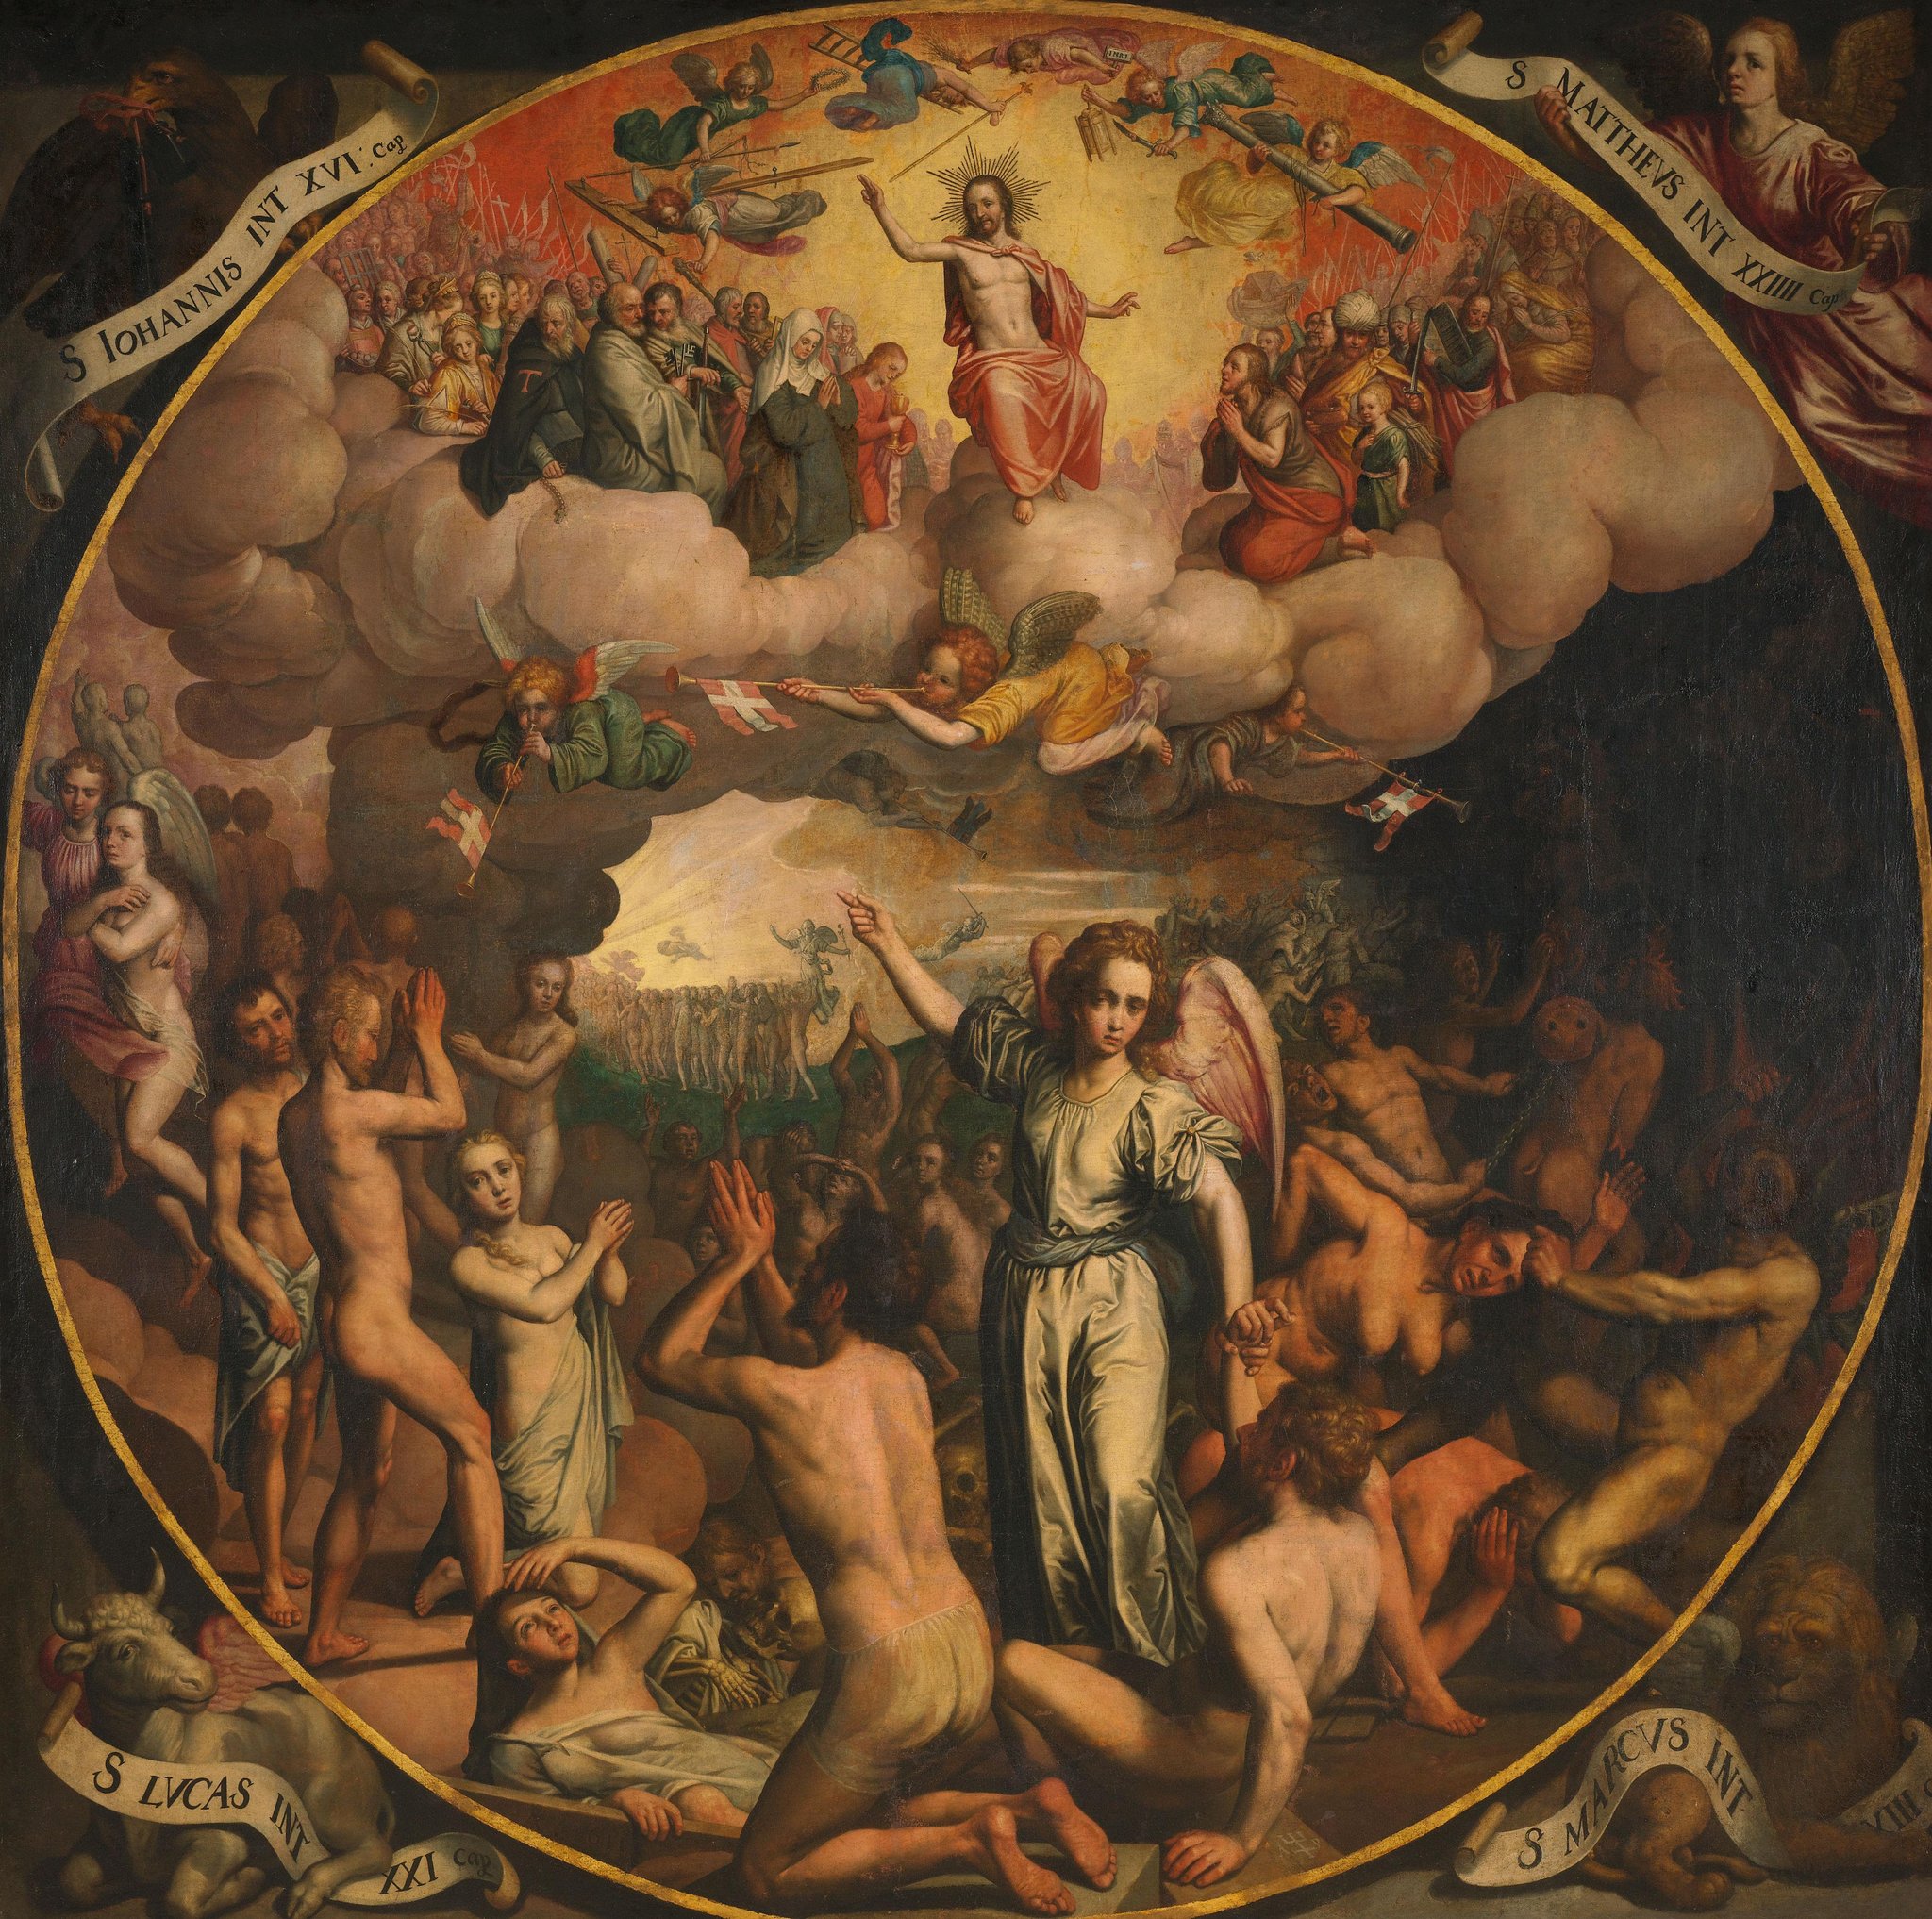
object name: painting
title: Last Judgment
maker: aert pietersz.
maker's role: draughtsman, painter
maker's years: 1550-1612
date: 1611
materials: canvas, oil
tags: comprehensive representation of last judgement: christ (with sword and lily), often surrounded by elders and sometimes accompanied by mary and john the baptist, appears in the sky with trumpeting angels (and sometimes angels holding the instruments of the passion); after the resurrection of the dead the blessed are led to heaven by angels, and the damned are dragged into hell by devils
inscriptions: signature and date: ‘A. 1611 AP’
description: Ronde voorstelling van het Laatste Oordeel. In de hemel troont Christus tussen heiligen en engelen met de passiewerktuigen. In de wolken blazen engelen op bazuinen. Op aarde rijzen de doden uit hun graven, in het midden de aartsengel Michaël. Links engelen met de geredde zielen, rechts trekken duivels aan de verdoemden. In de vier hoeken de symbolen van de evangelisten met banderollen.